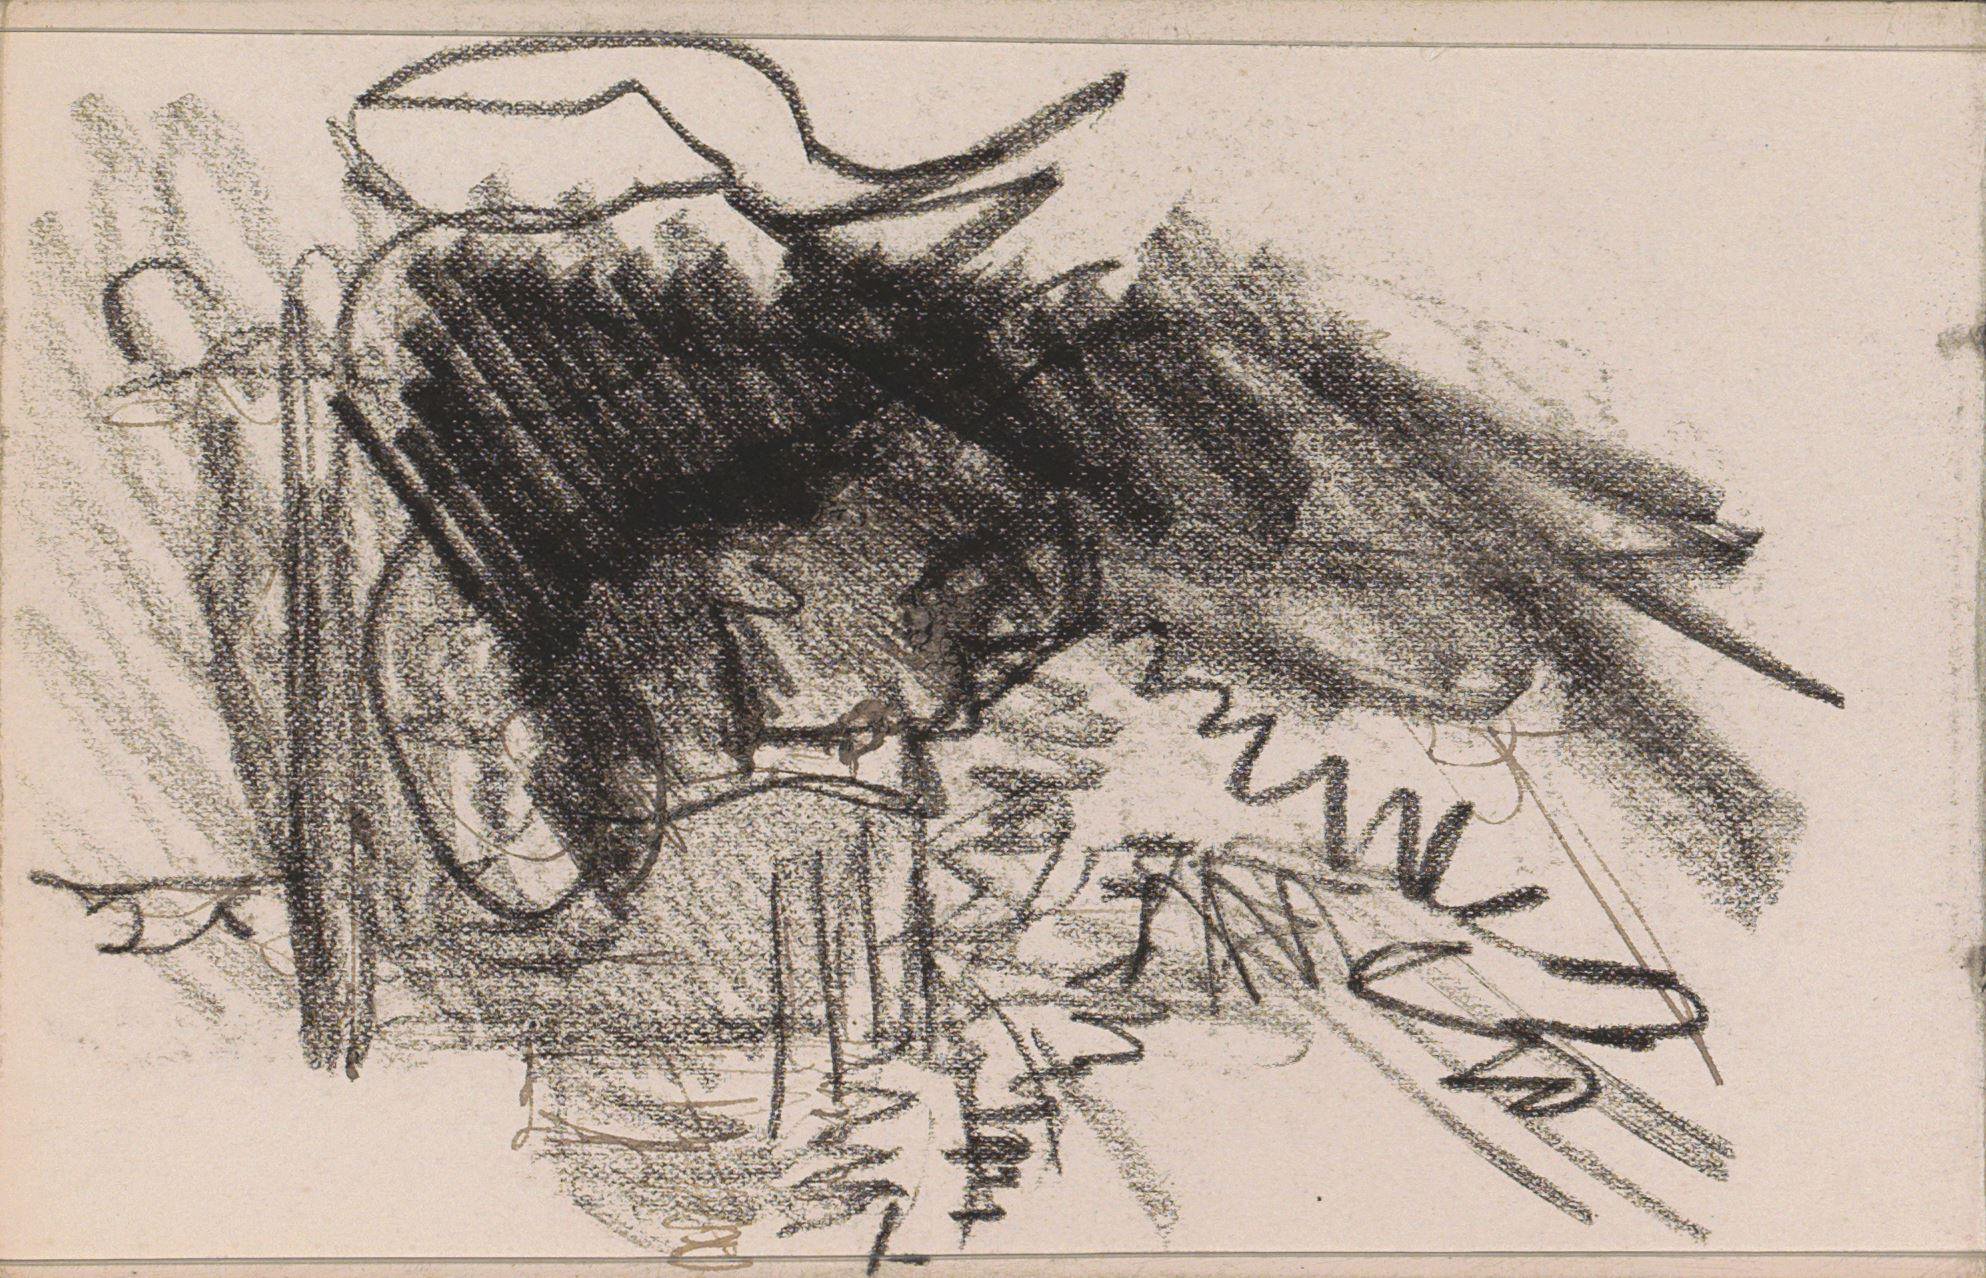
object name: sketchbook leaf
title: Vrouw, mogelijk op een balkon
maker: isaac israels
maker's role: draughtsman, painter, print maker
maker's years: 1865-1934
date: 1887-1934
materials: chalk, paper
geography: paris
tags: adult woman (+ sideview, profile), balcony, street (+ city(-scape) with figures, staffage), paris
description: Op de achtergrond een straat, mogelijk in Parijs. In de verte een gebouw met vlaggen. Pagina 15 uit schetsboek XLIX met 32 pagina's.